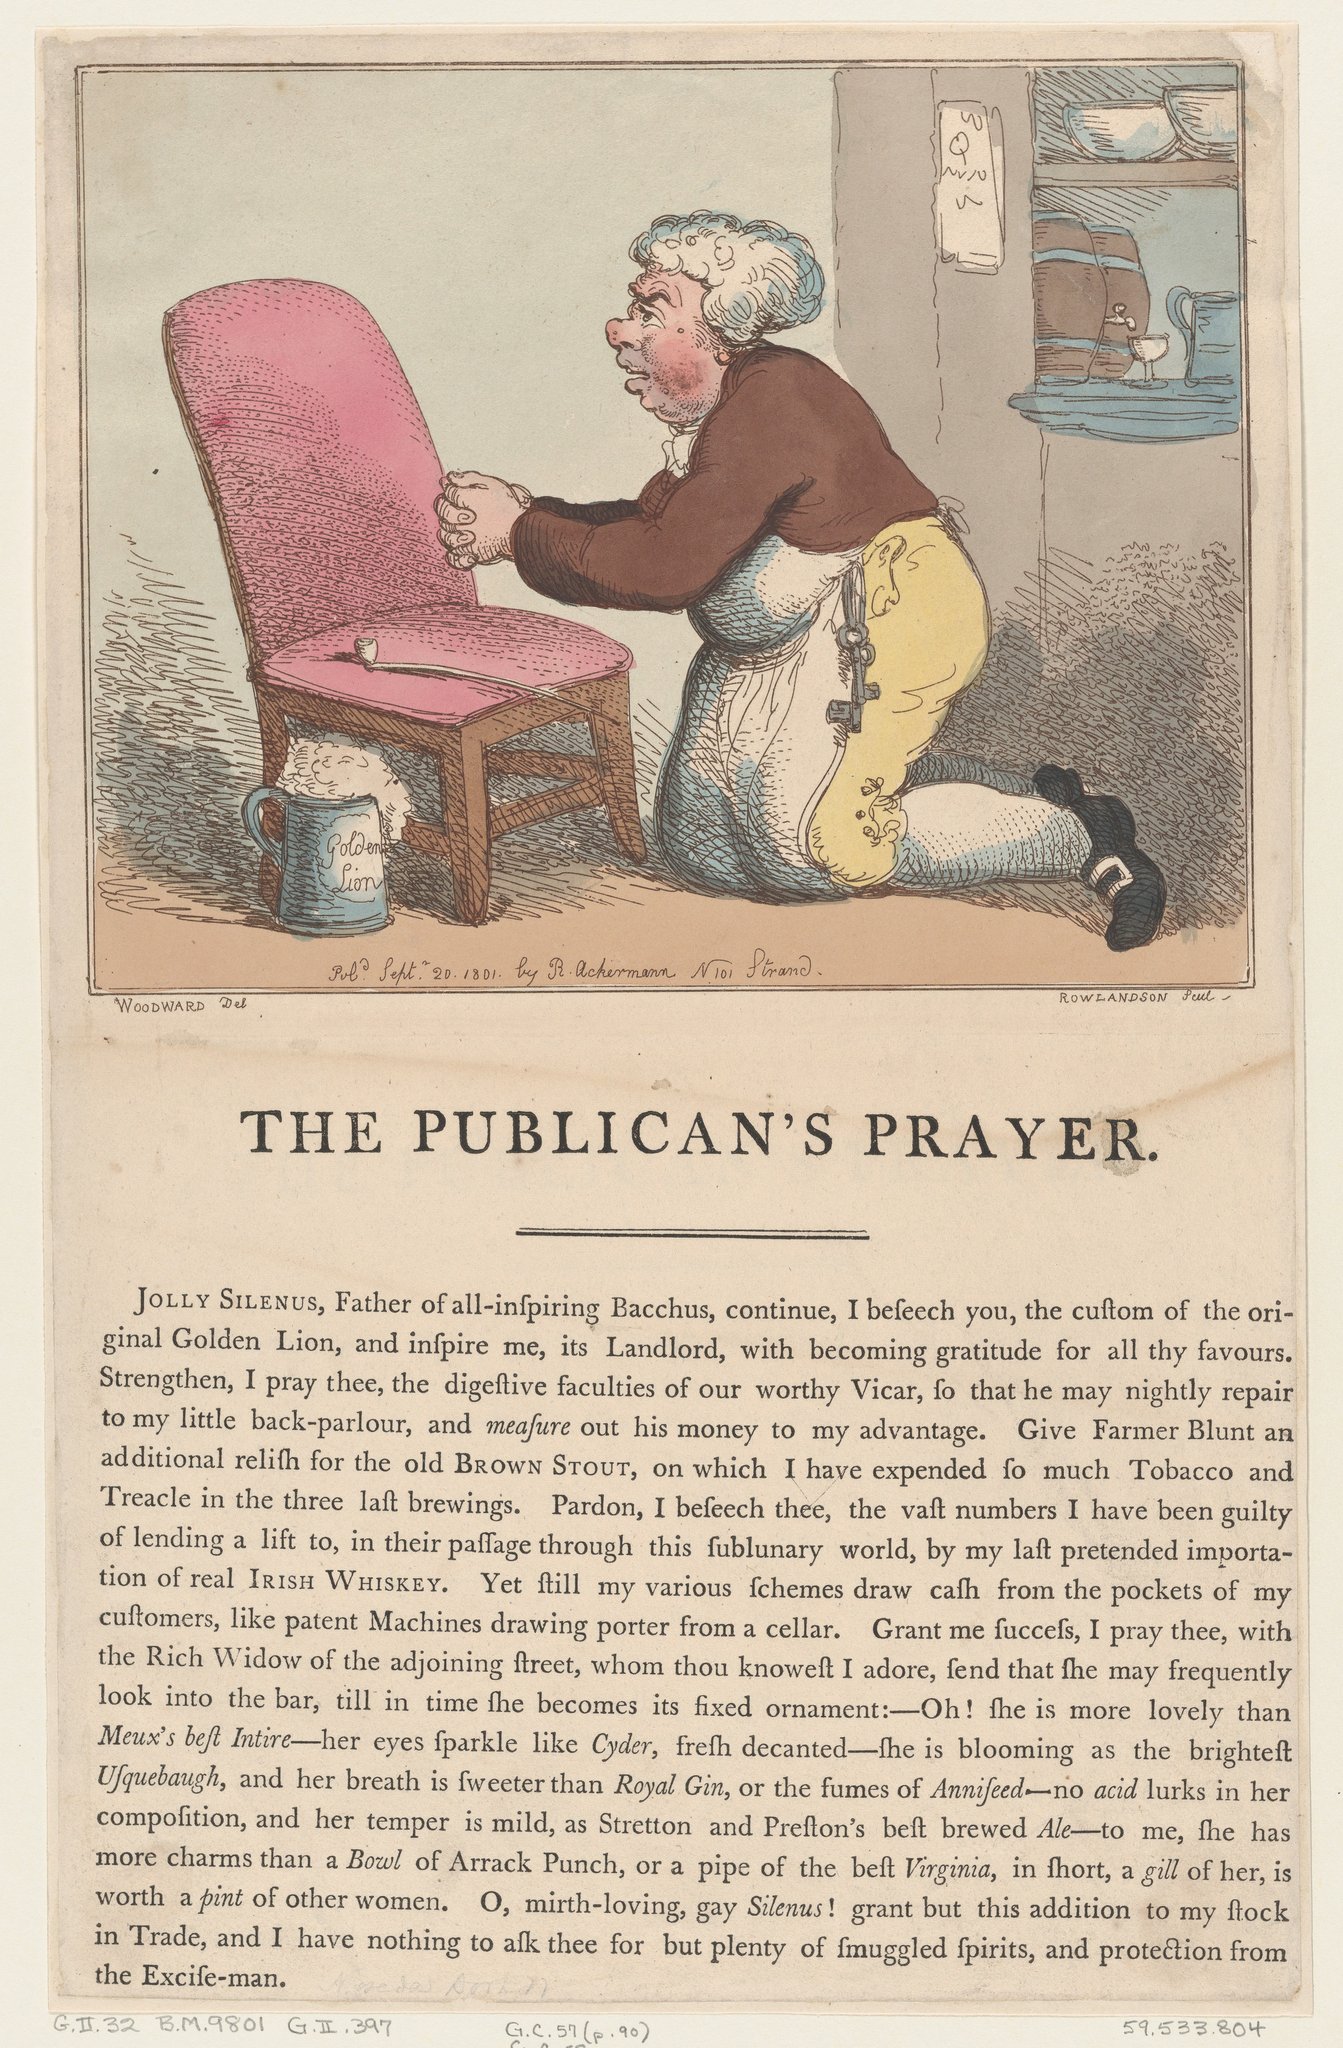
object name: print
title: The Publican's Prayer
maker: thomas rowlandson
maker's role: artist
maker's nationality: british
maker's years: 1757-1827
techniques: etching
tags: women,praying,chairs